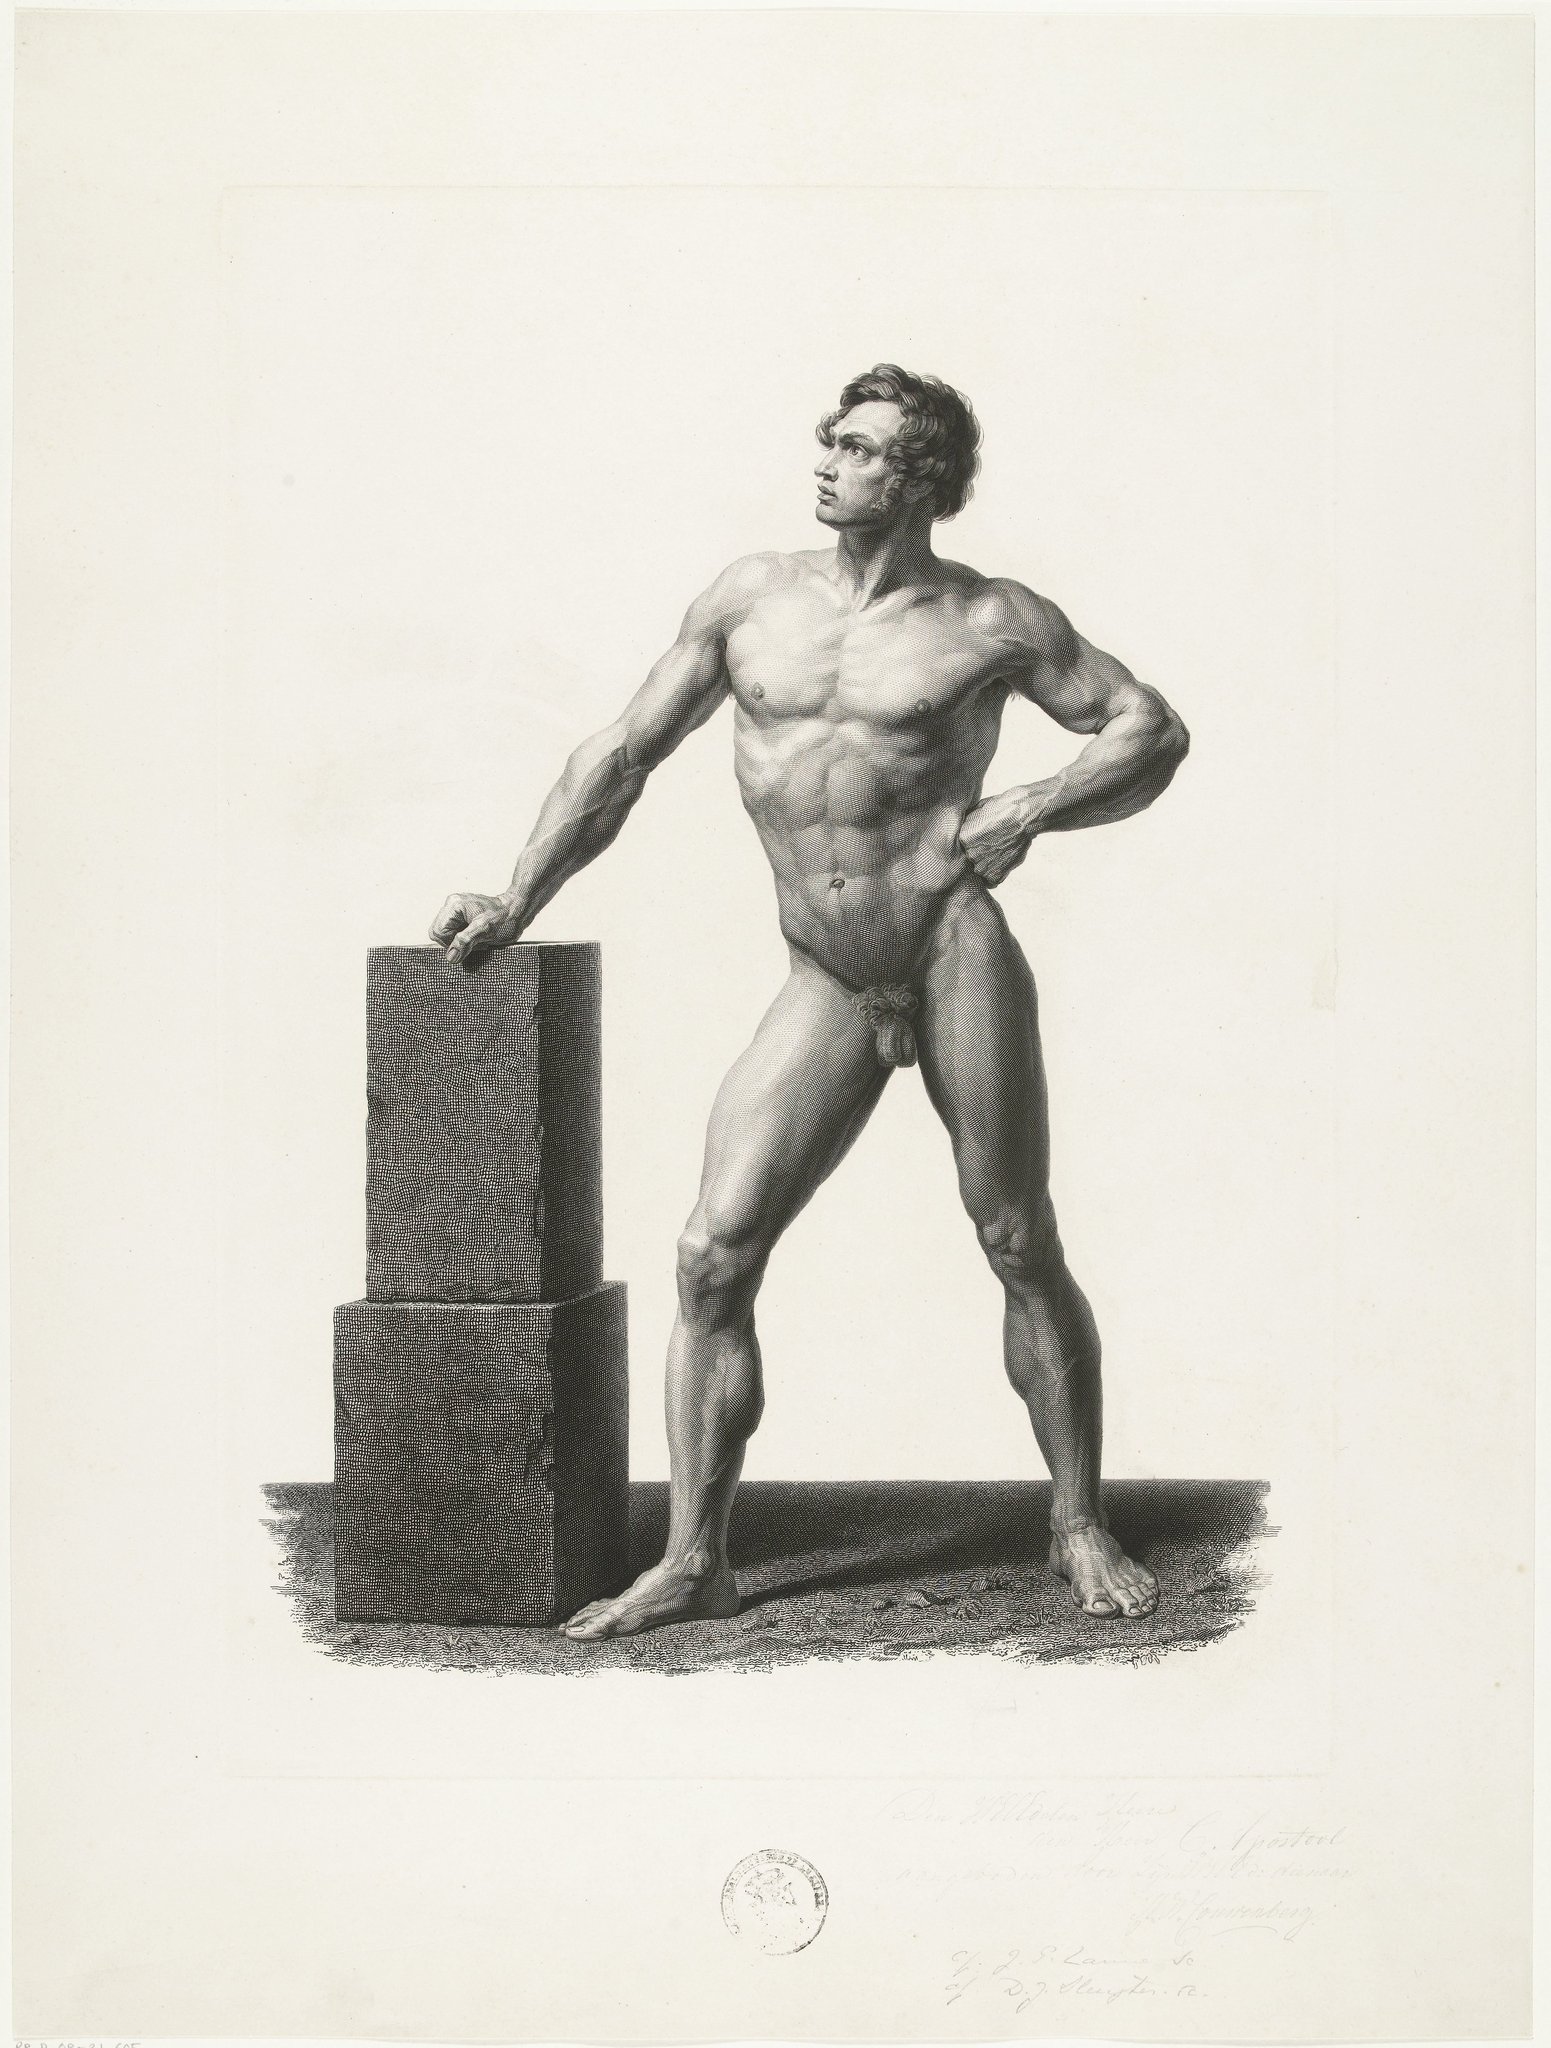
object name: print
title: Naakte man, met de rechterhand op een stenen blok leunend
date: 1836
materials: paper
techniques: engraving, etching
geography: amsterdam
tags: the (nude) human figure; 'corpo humano' (ripa) (+ standing)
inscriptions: stamp: Lugt 10, collector's mark: Lugt 2228